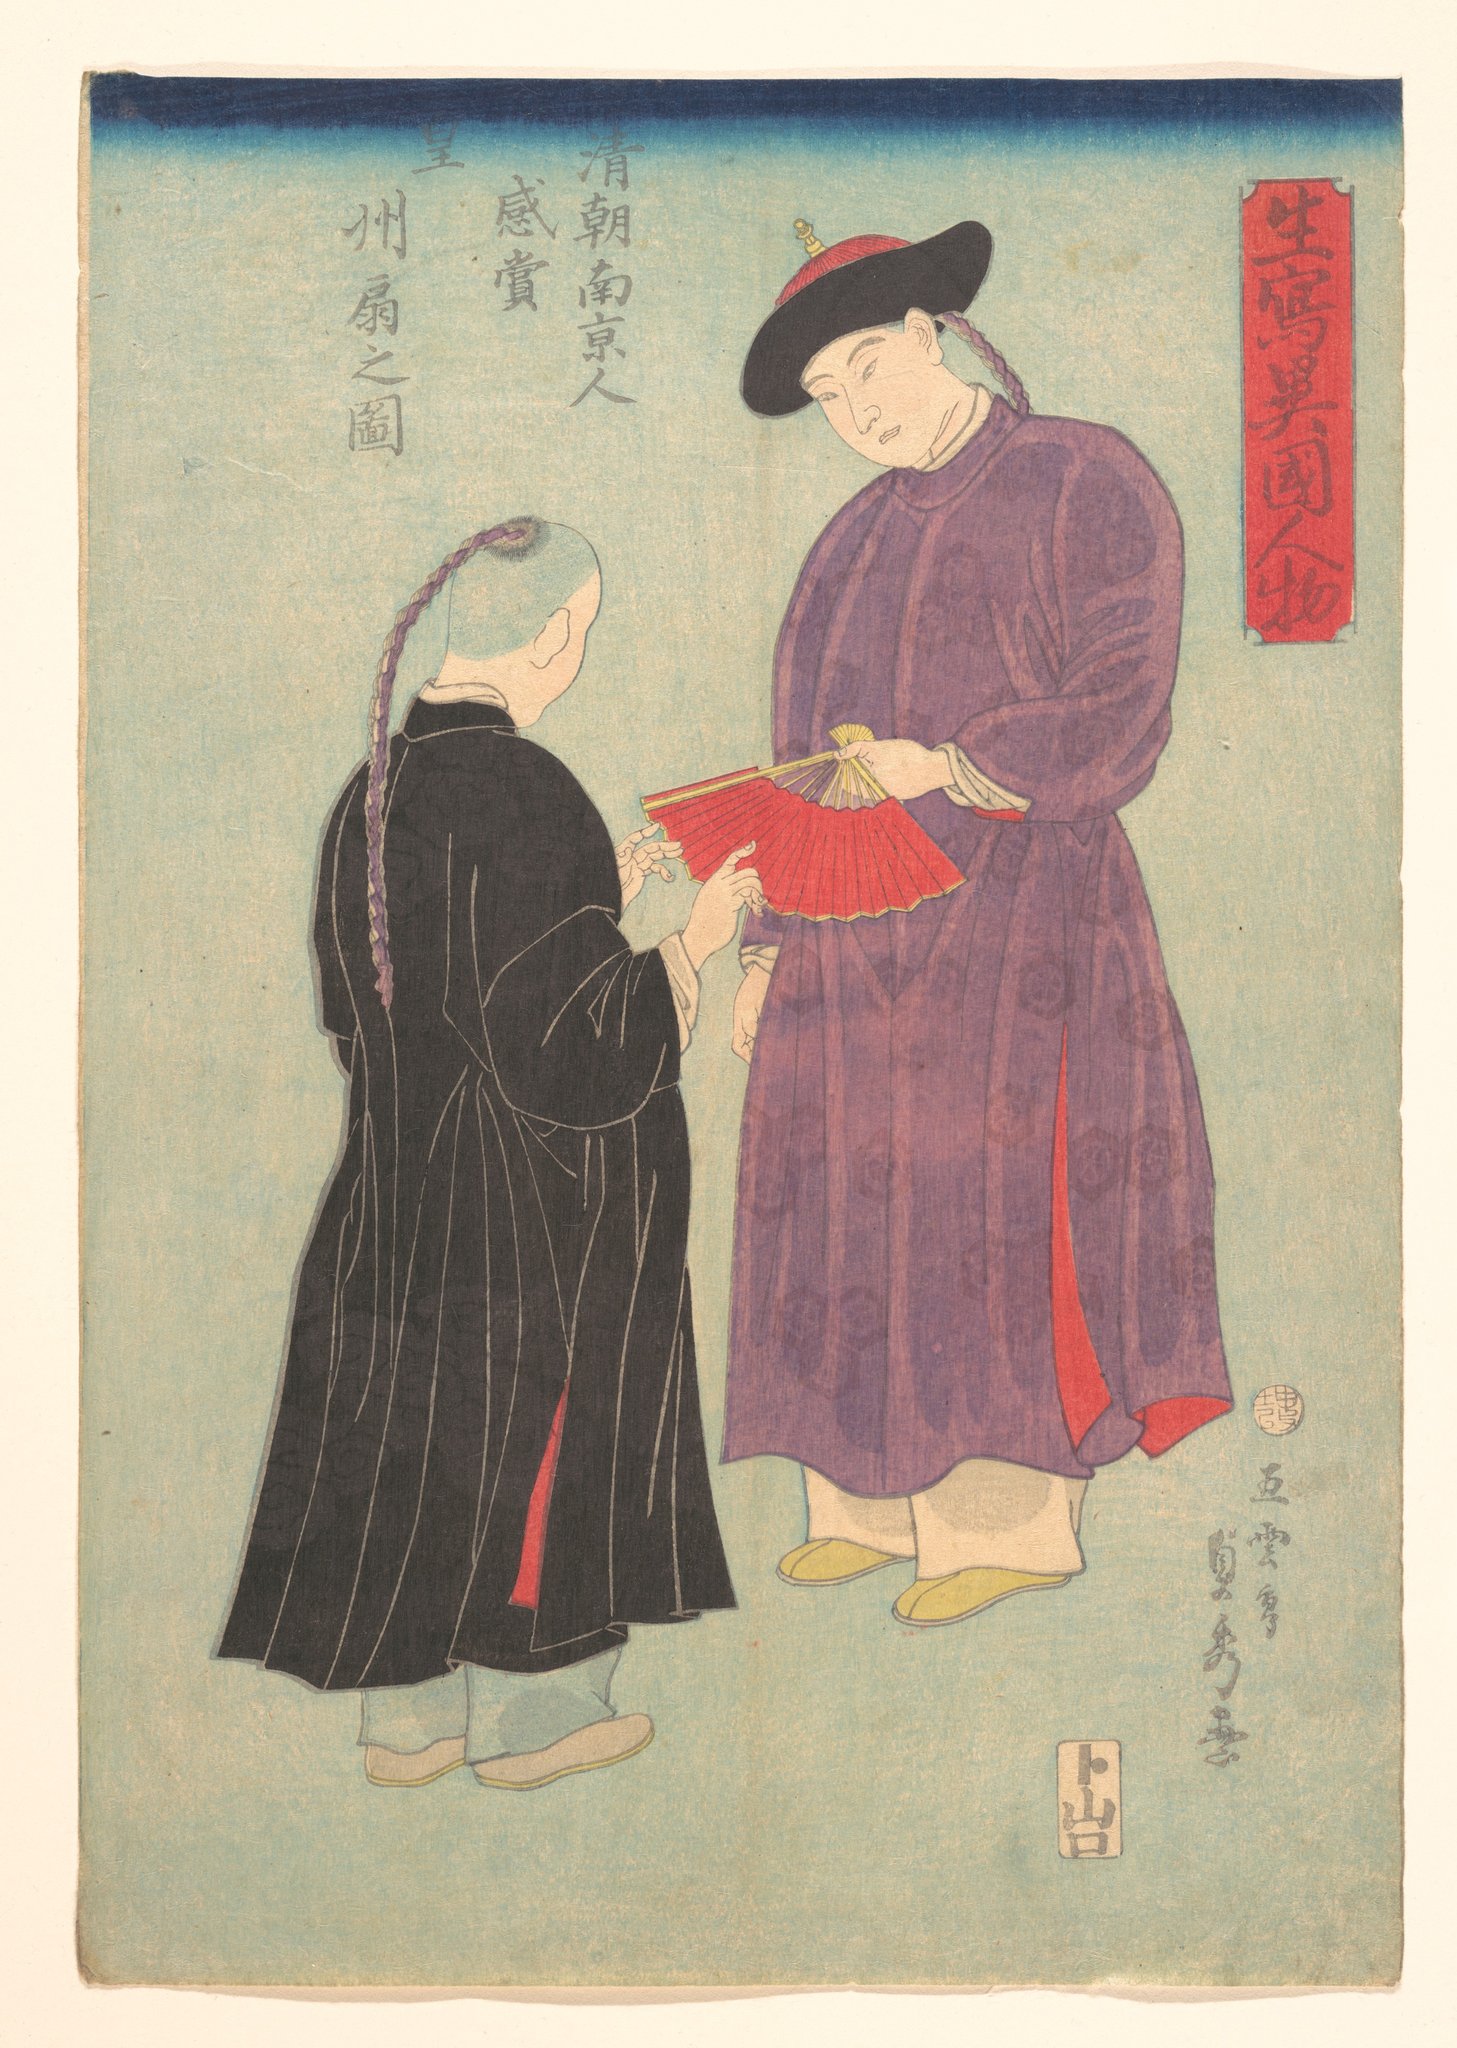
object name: print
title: Picture of a Manchurian of the Qing Court from Nanjing, Admiring a Fan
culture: japanese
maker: utagawa (gountei) sadahide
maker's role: artist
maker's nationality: japanese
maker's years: 1807-1873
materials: ink, paper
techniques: woodblock print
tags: fans,men